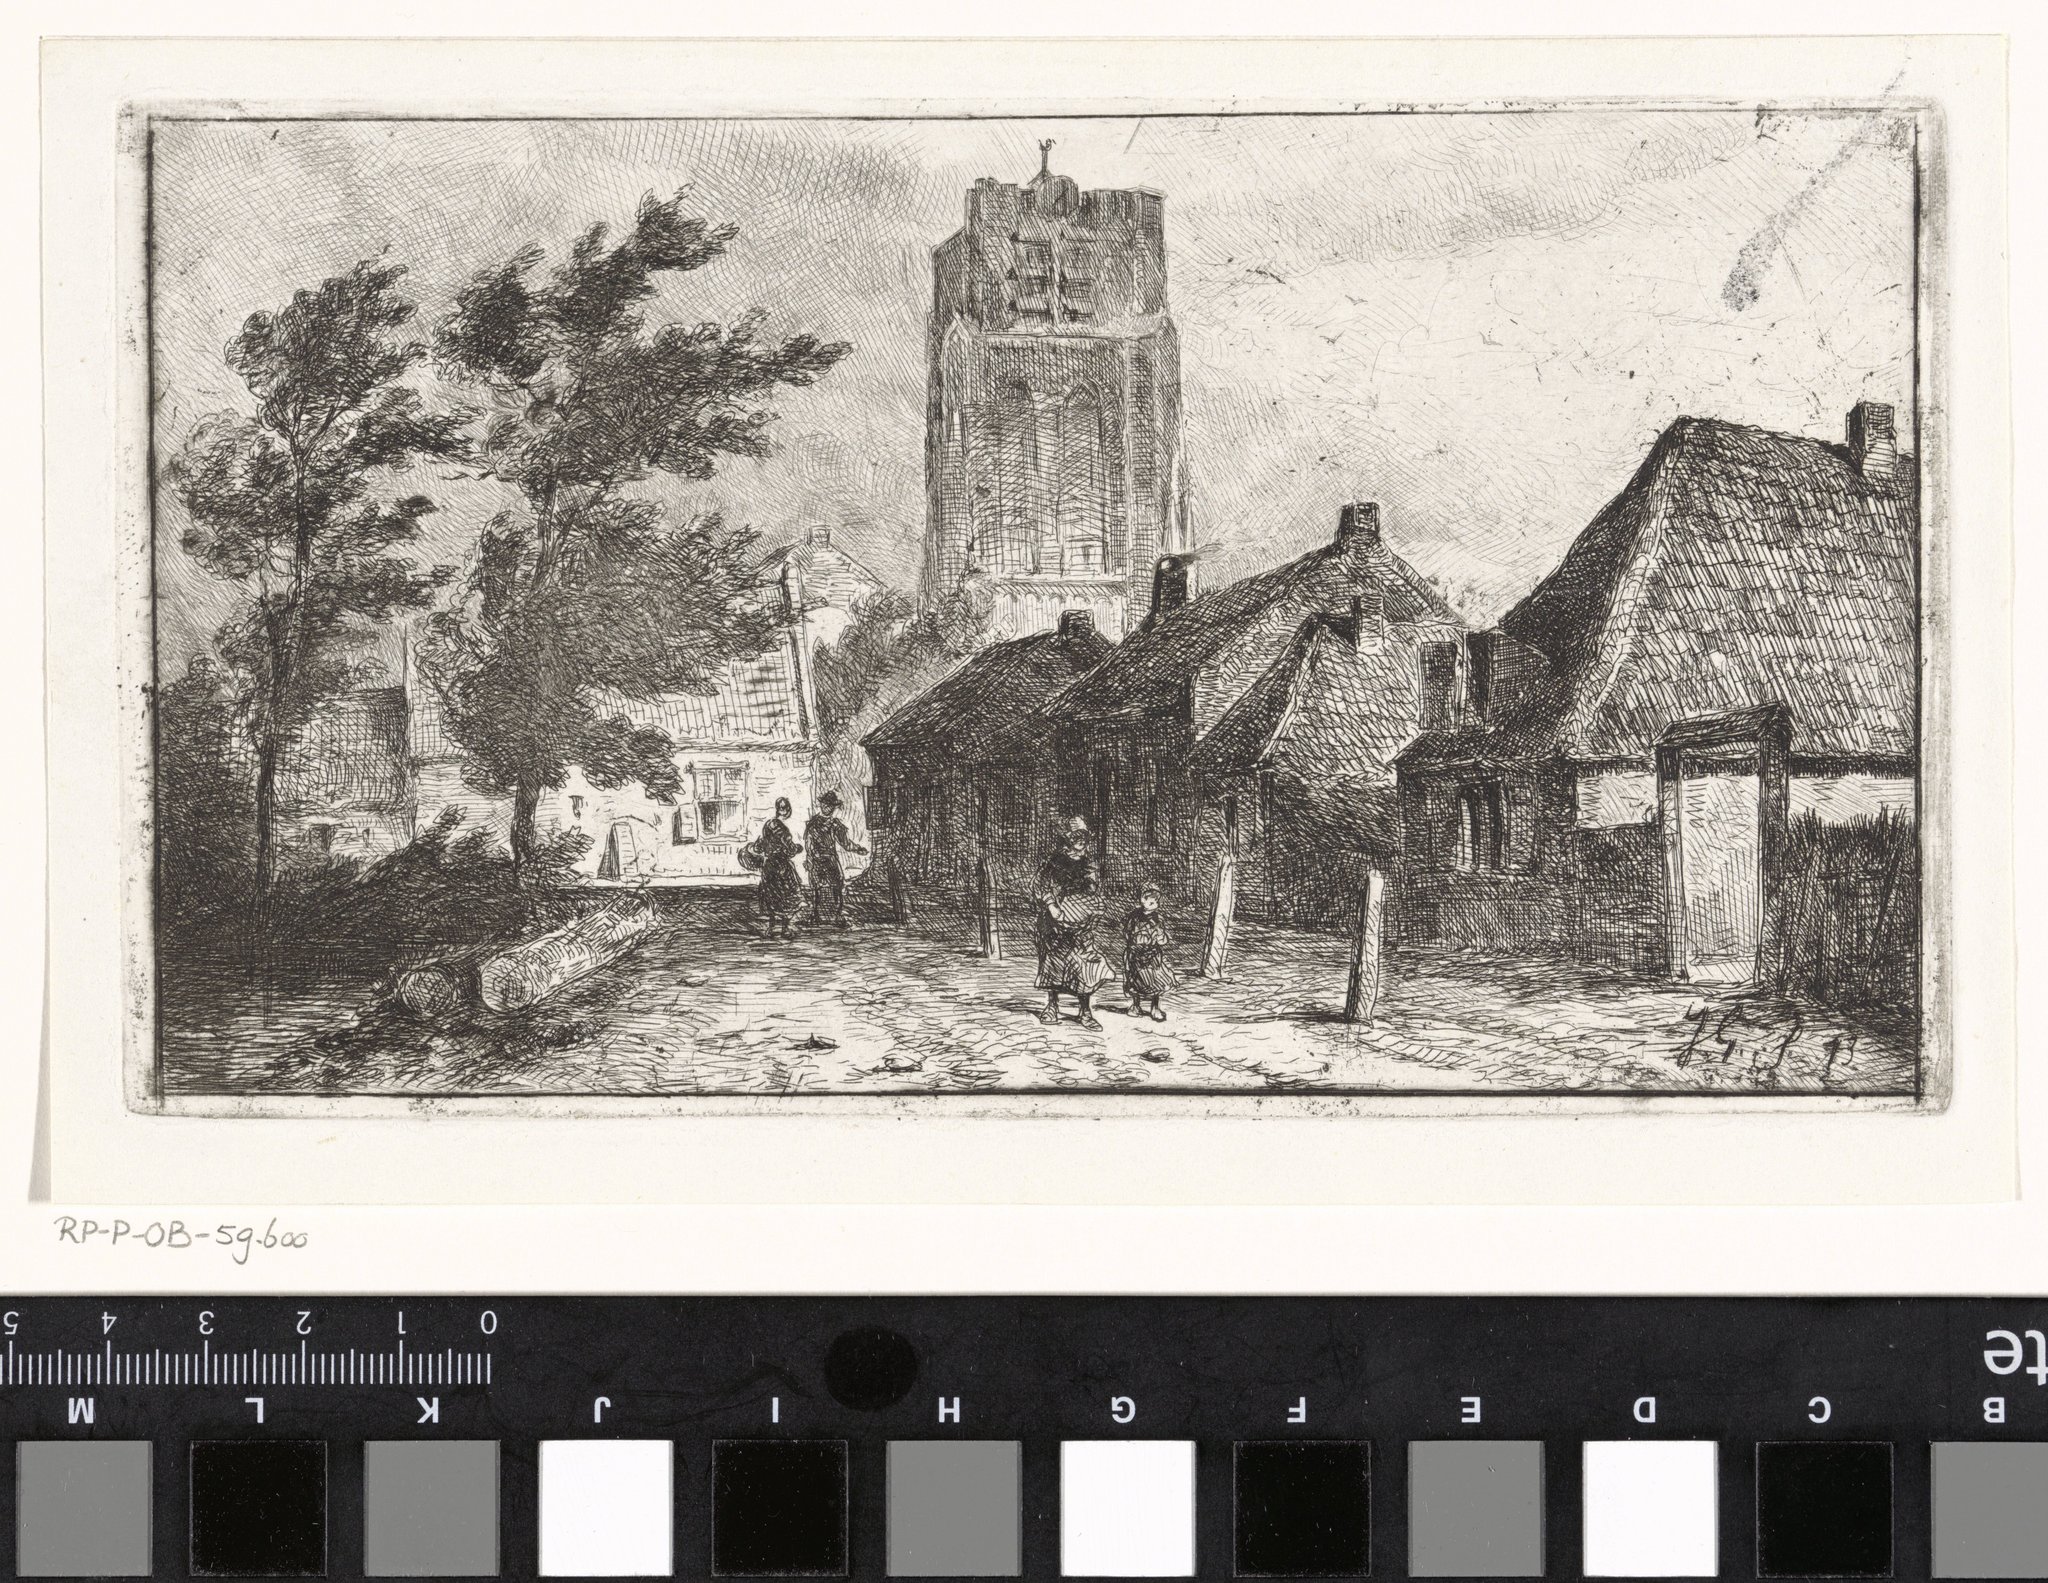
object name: print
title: Dorpsgezicht met kerktoren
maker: jan gerard smits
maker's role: draughtsman, print maker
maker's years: 1823-1910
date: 1873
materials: paper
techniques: drypoint, etching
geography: the hague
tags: public road in village, wijk bij duurstede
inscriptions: collector's mark: Lugt 2228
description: Dorpsstraat met wandelende mensen. Op de achtergrond een forse kerktoren. Mogelijk Wijk bij Duurstede?